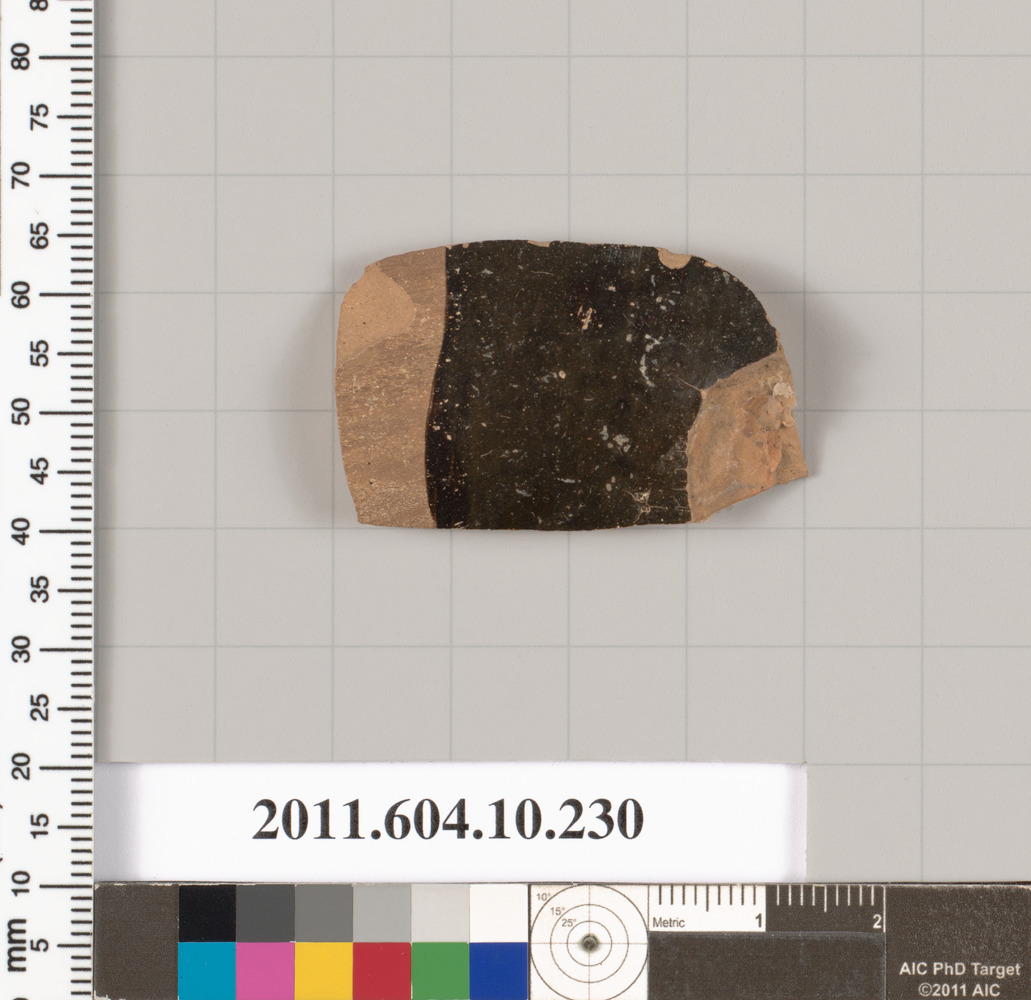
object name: undetermined closed shape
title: Terracotta fragment of a closed shape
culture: etruscan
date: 601-700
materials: terracotta